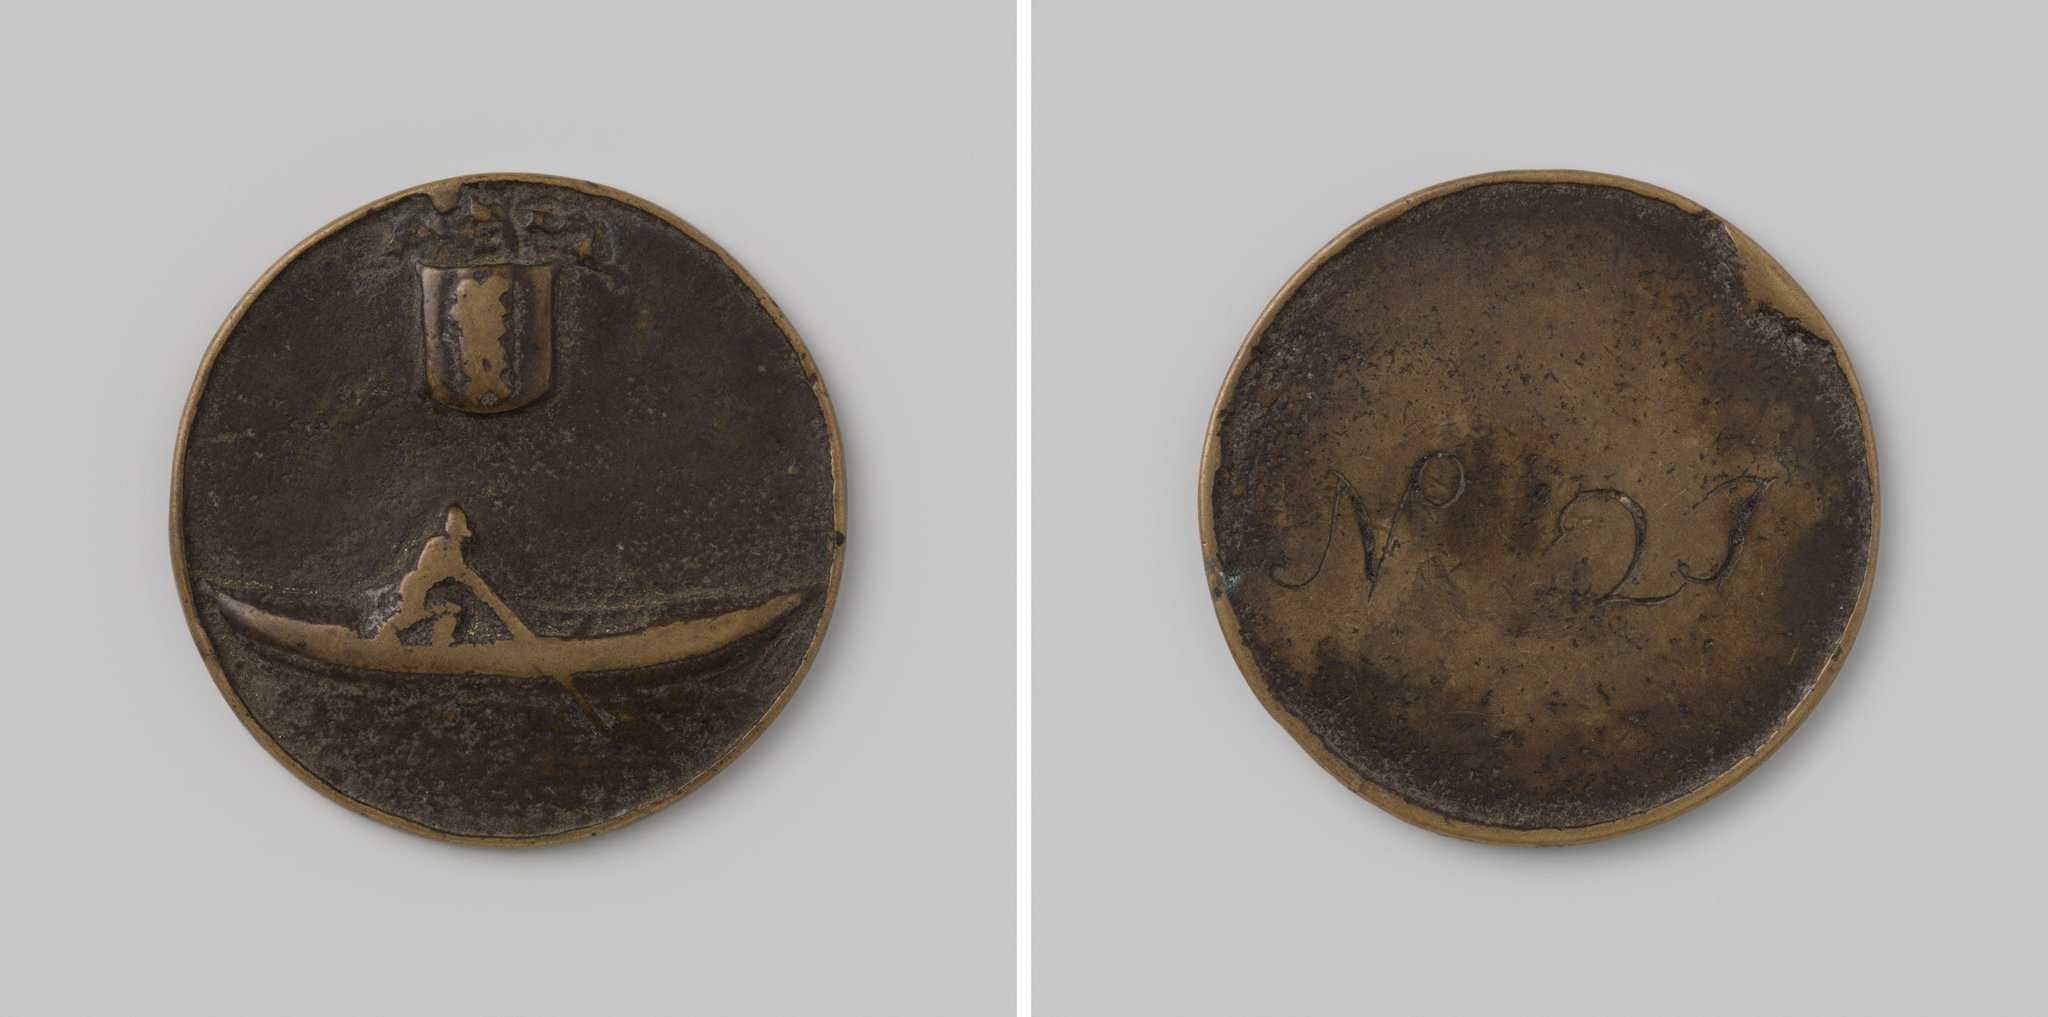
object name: history medal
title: Moddermanspenning van het Aalmoezeniersweeshuis te Amsterdam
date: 1600-1800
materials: brass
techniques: casting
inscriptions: inscription: ‘N° 21’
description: Gegoten messing penning, op de voorzijde een schuit met roeier onder een wapenschild Amsterdam, op de keerzijde het cijfer 21